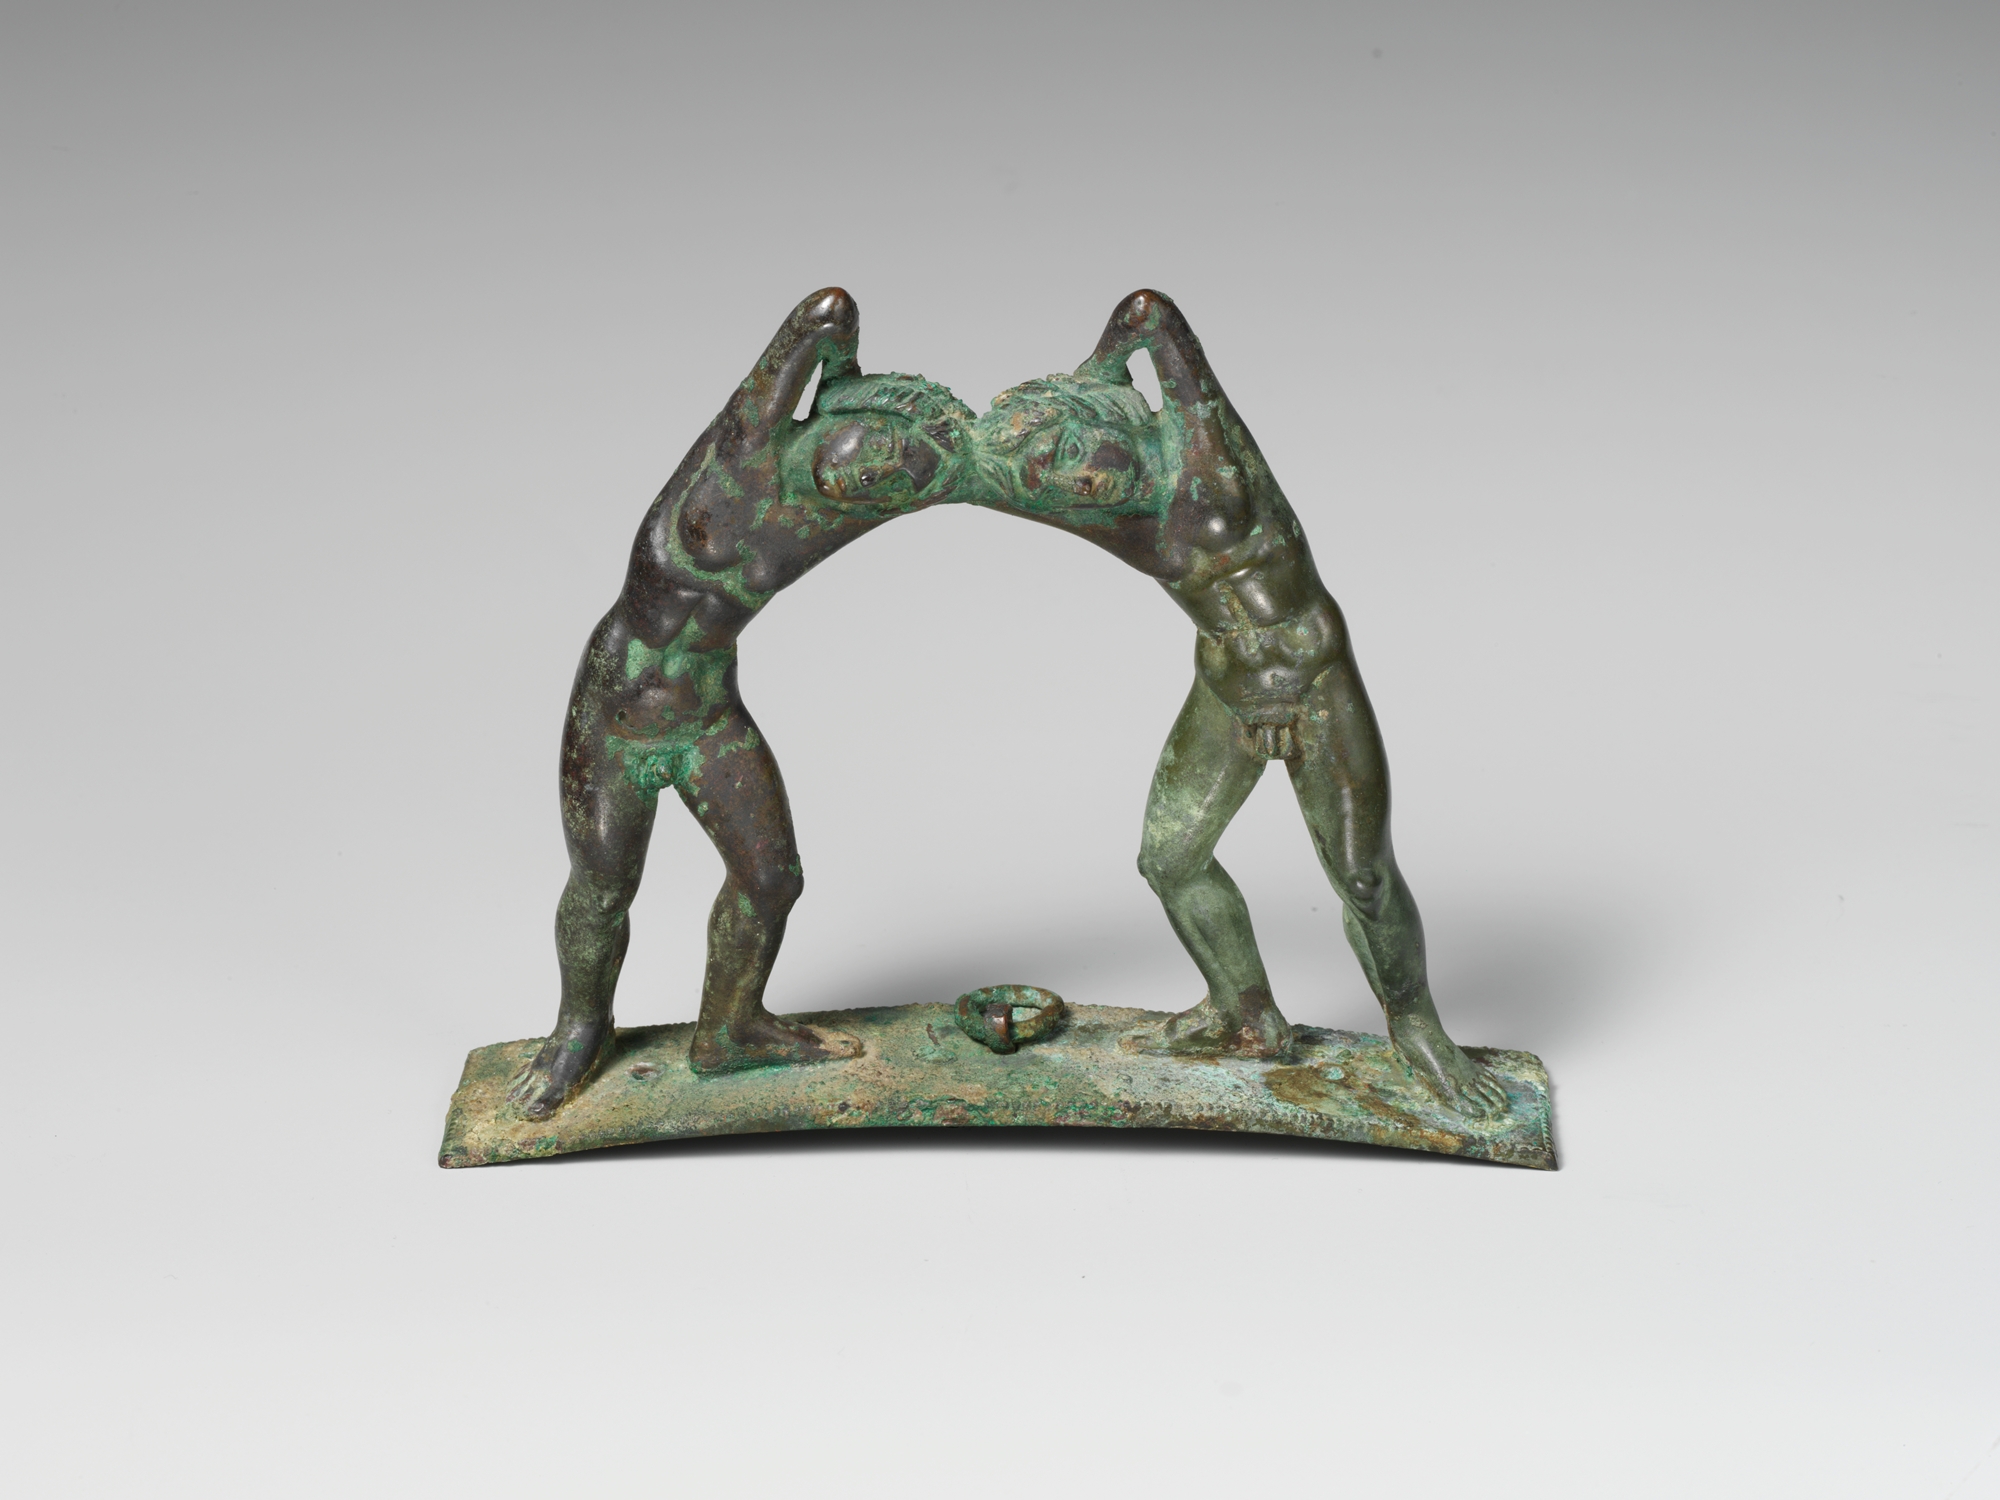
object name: handle of a cista lid or box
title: Bronze handle from a cista (toiletries box)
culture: praenestine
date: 400-301 BCE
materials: bronze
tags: male nudes